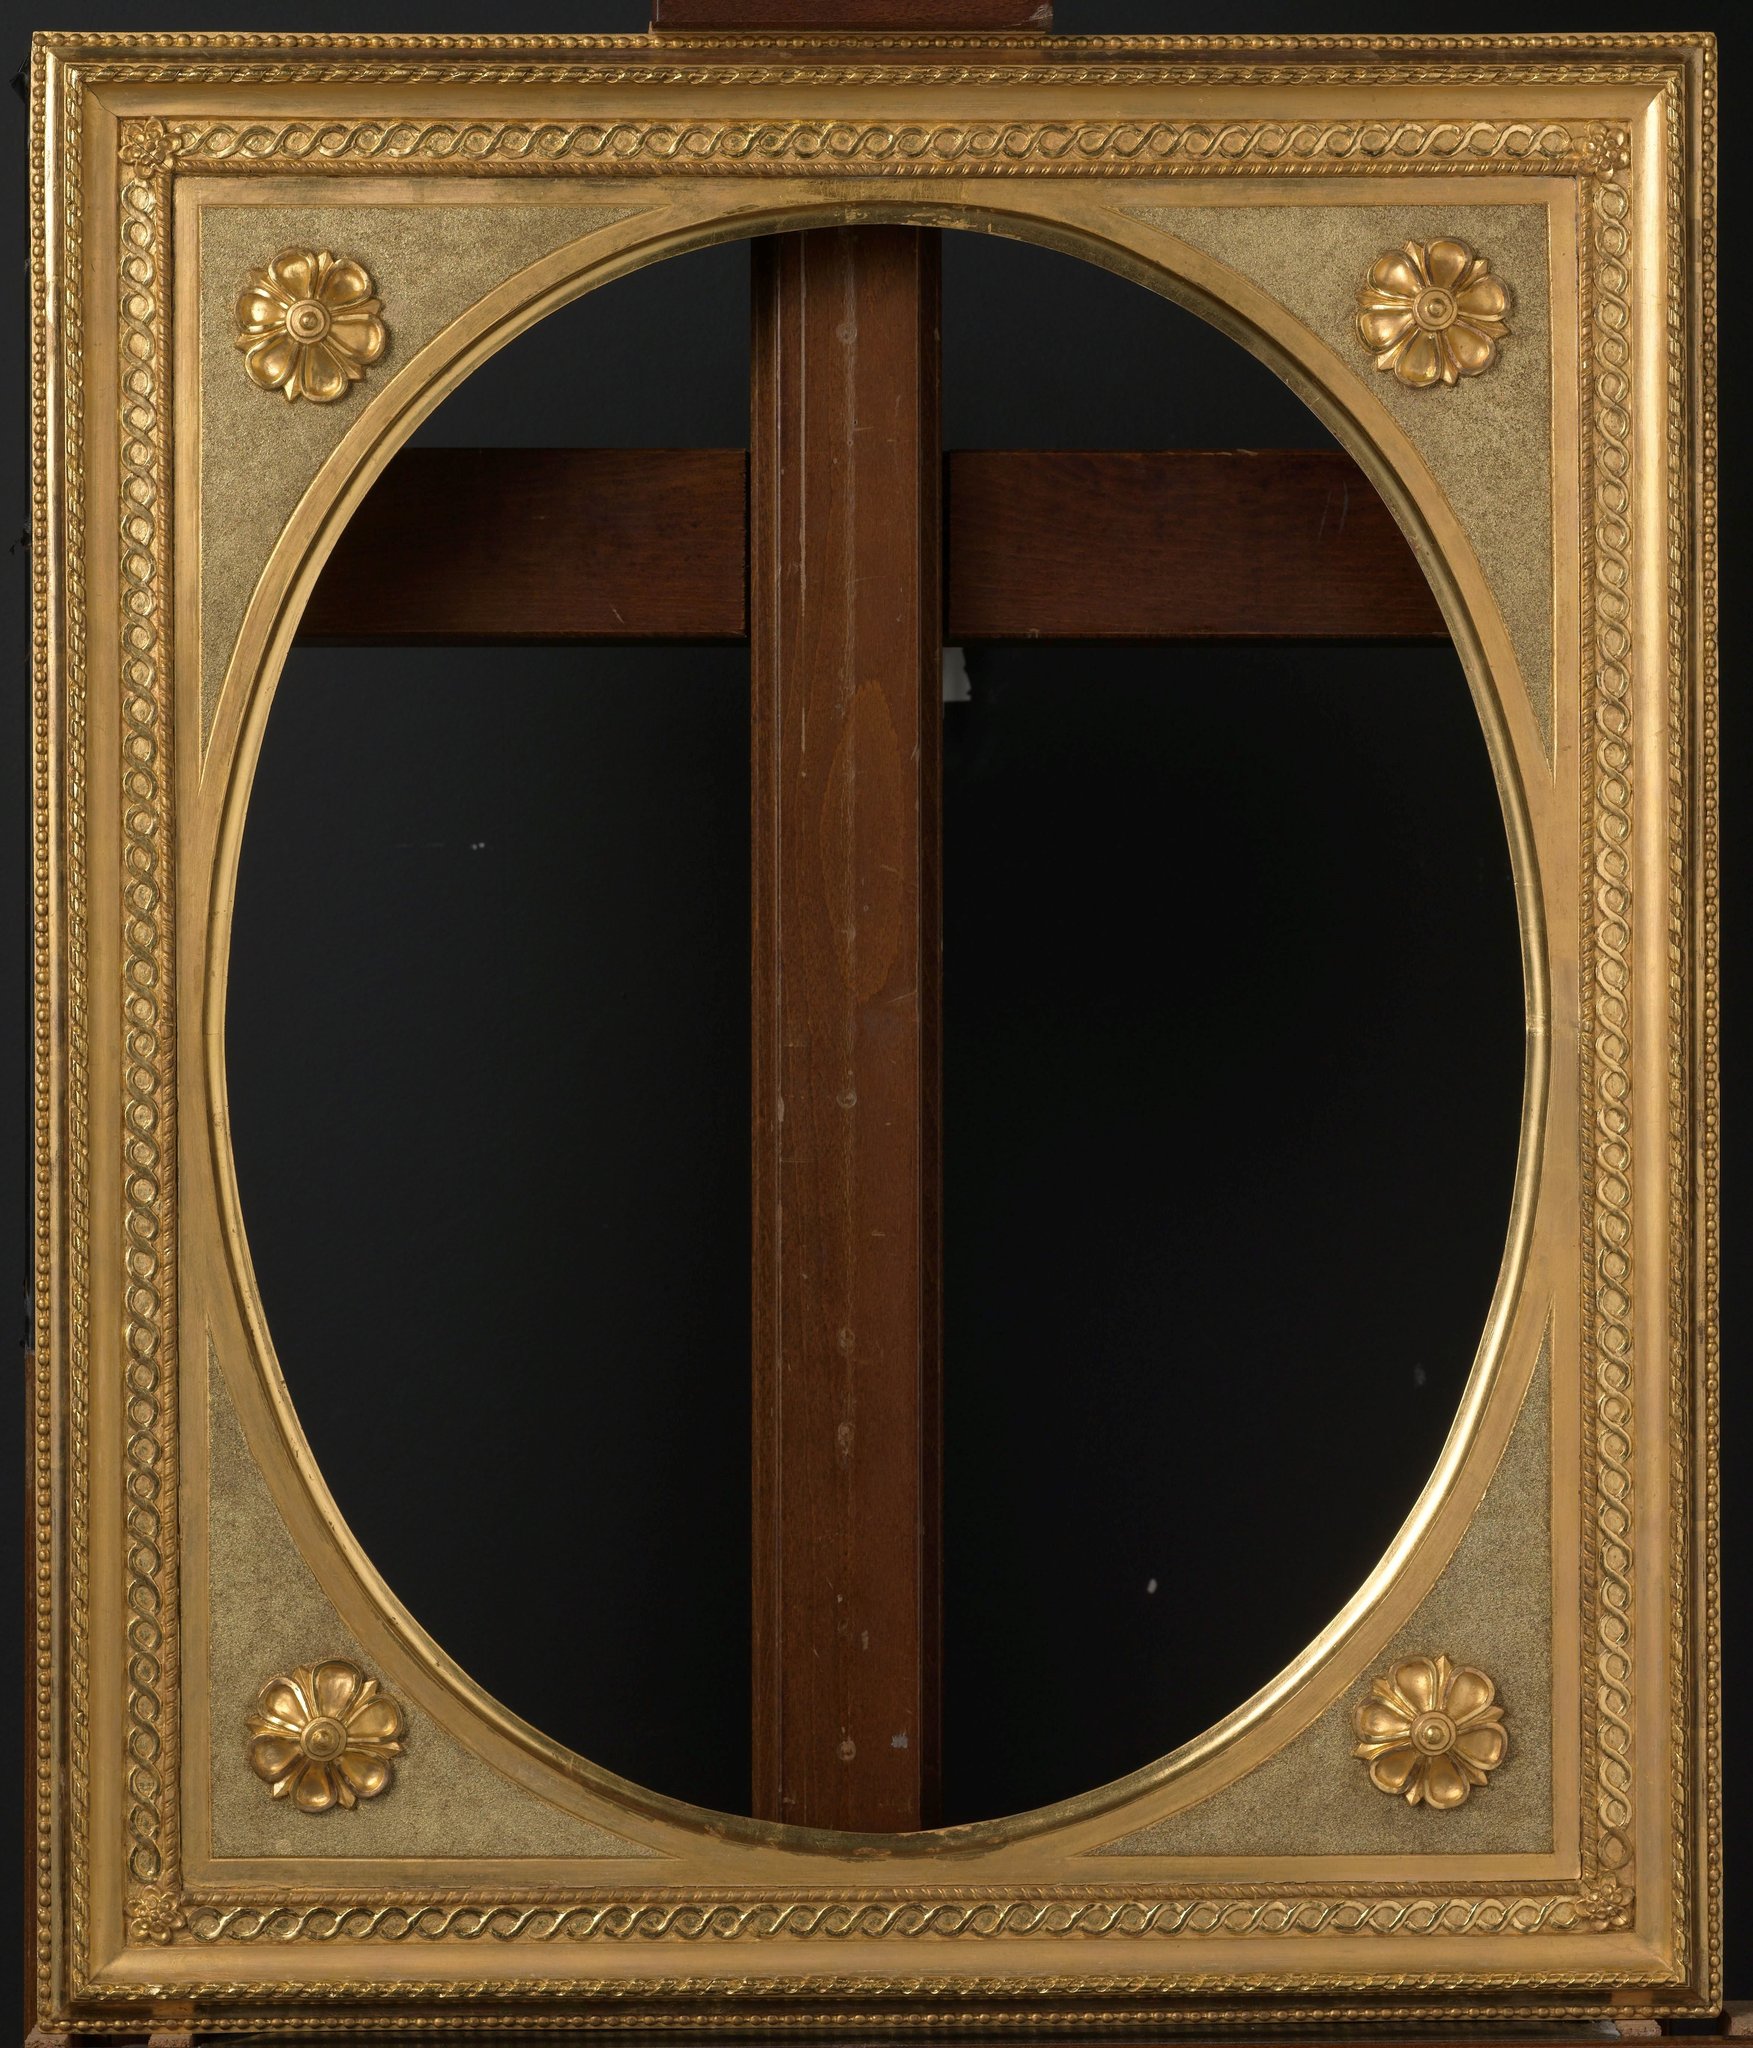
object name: frame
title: Schilderijlijst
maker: hendrik ebbens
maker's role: lijstenmaker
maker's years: 1726-1807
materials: wood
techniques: gilding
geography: the hague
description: Rechthoekig verguld kader waarin een ovaal is uitgespaard. De buitenrand versierd met een parelrand, daarbinnen een verhoogde rand met gedraaid lintmotief, daarbinnen een slingerrand met rozetjes op de hoeken. In de hoeken een rozet. Aan de bovenregel en onderregel uitstekende randen met de namen van de vervaardiger en de voorgestelde.